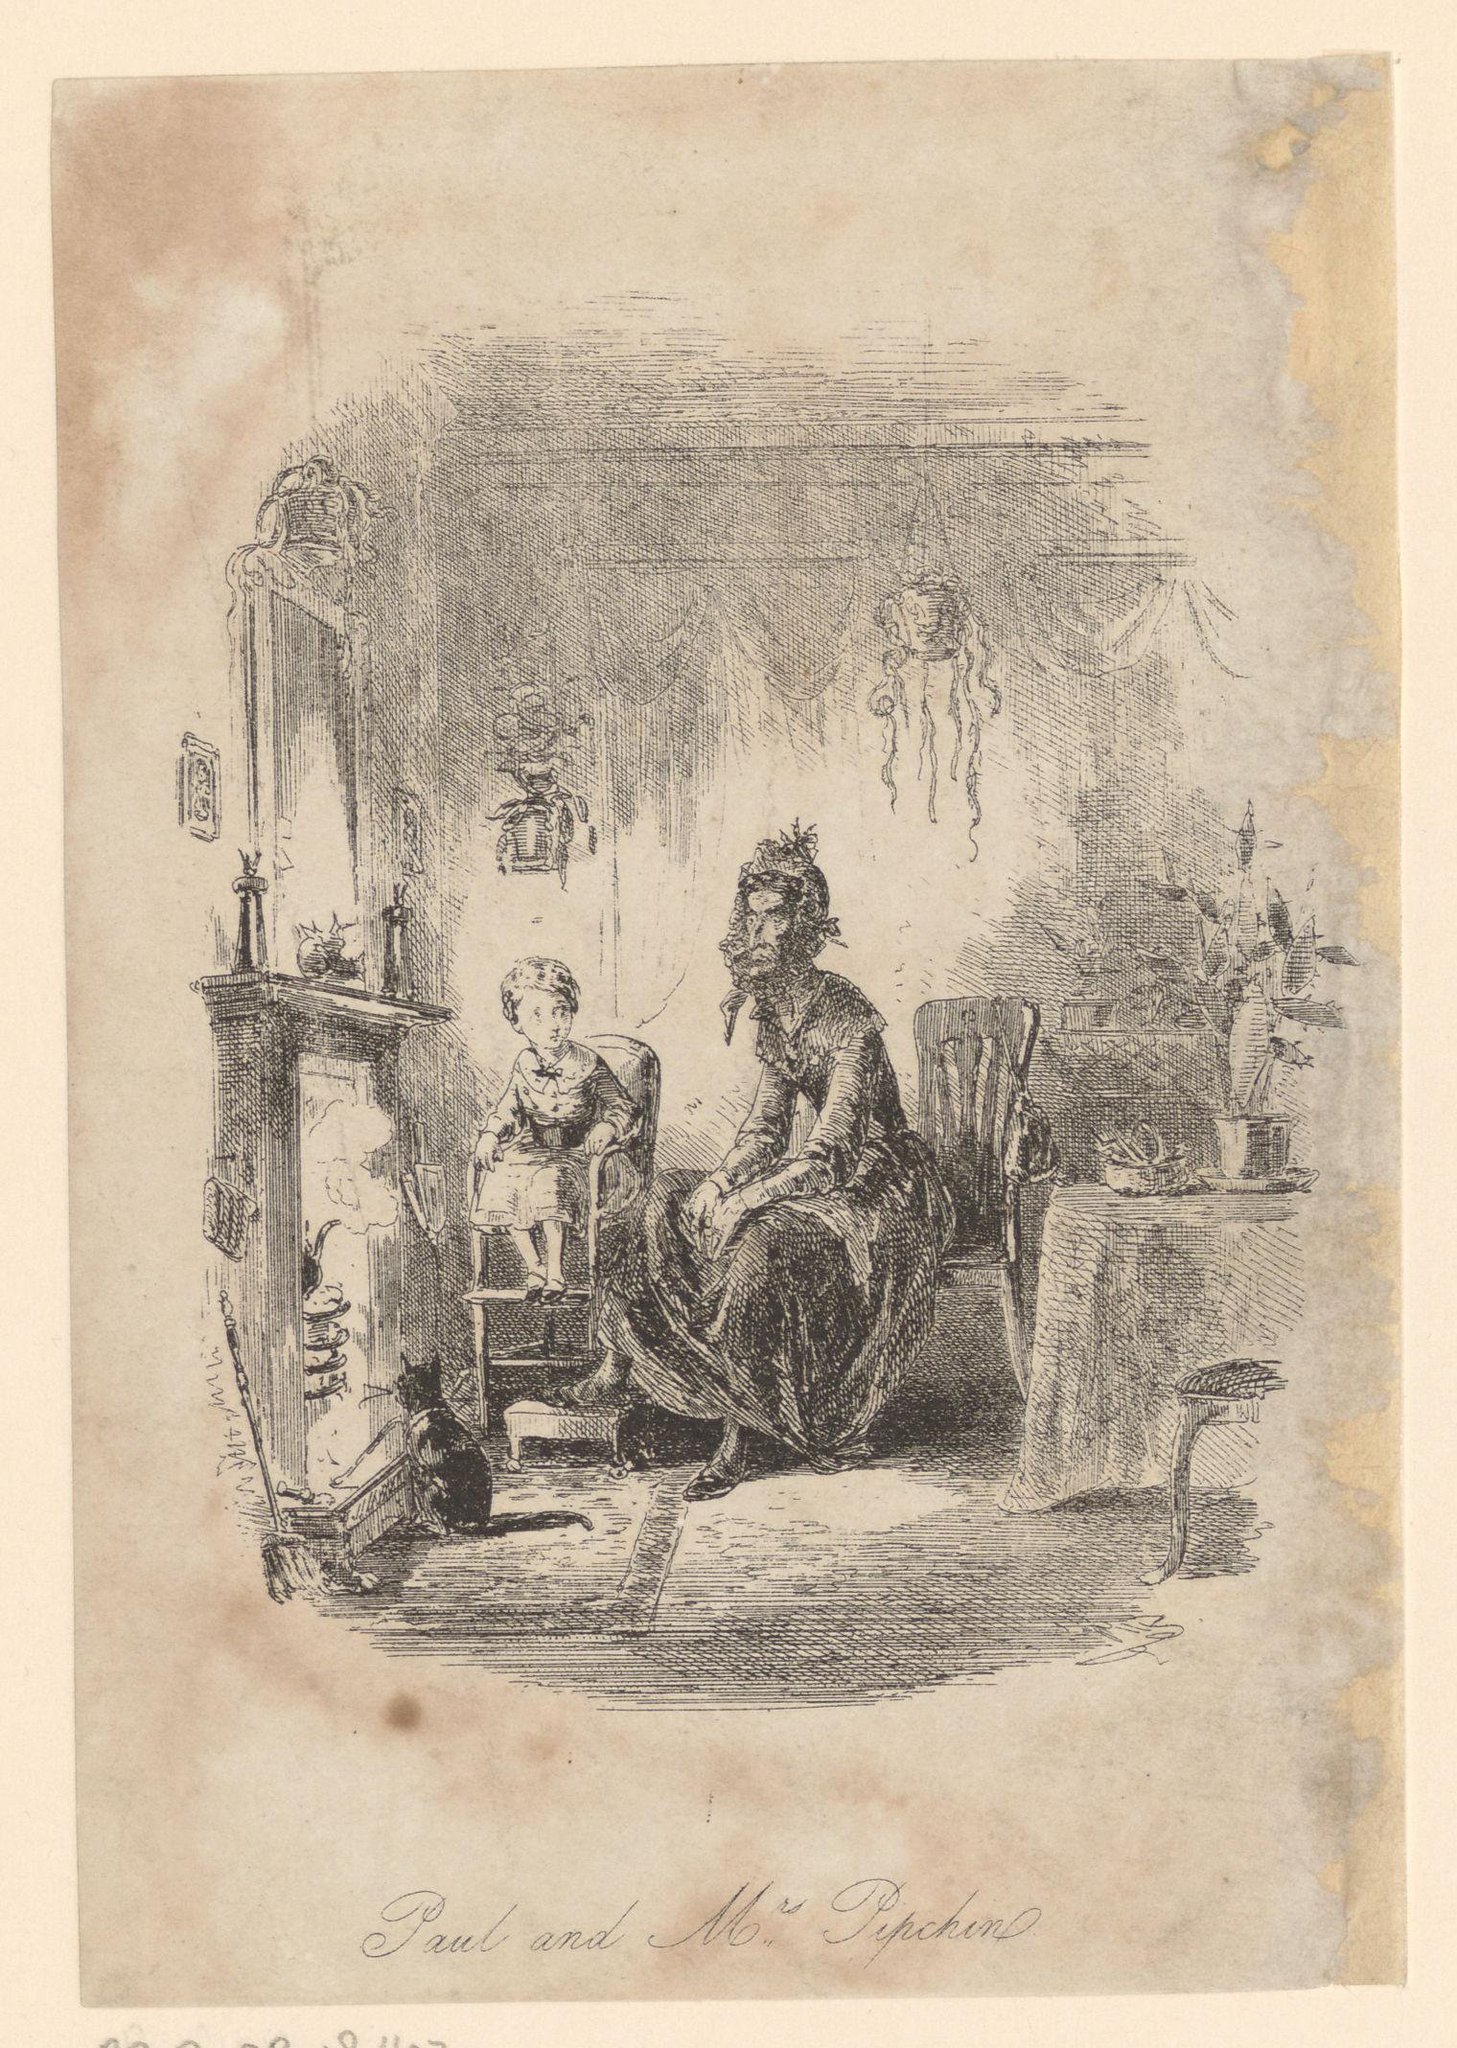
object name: book illustration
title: Paul and Mrs. Pipchin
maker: hablot knight browne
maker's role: print maker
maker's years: 1815-1882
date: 1846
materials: paper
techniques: etching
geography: london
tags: child, open hearth, fire-place, ugly old woman, hag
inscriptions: collector's mark: Lugt 2228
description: Prent uit: Dickens, Charles. Dealings with the Firm of Dombey and Son: Wholesale, Retail and for Exportation. Londen: Bradbury & Evans, 1846-1848. Het boek werd tussen 1846 en 1848 in delen maandelijks uitgegeven, alvorens het in 1848 gebundeld werd uitgegeven.